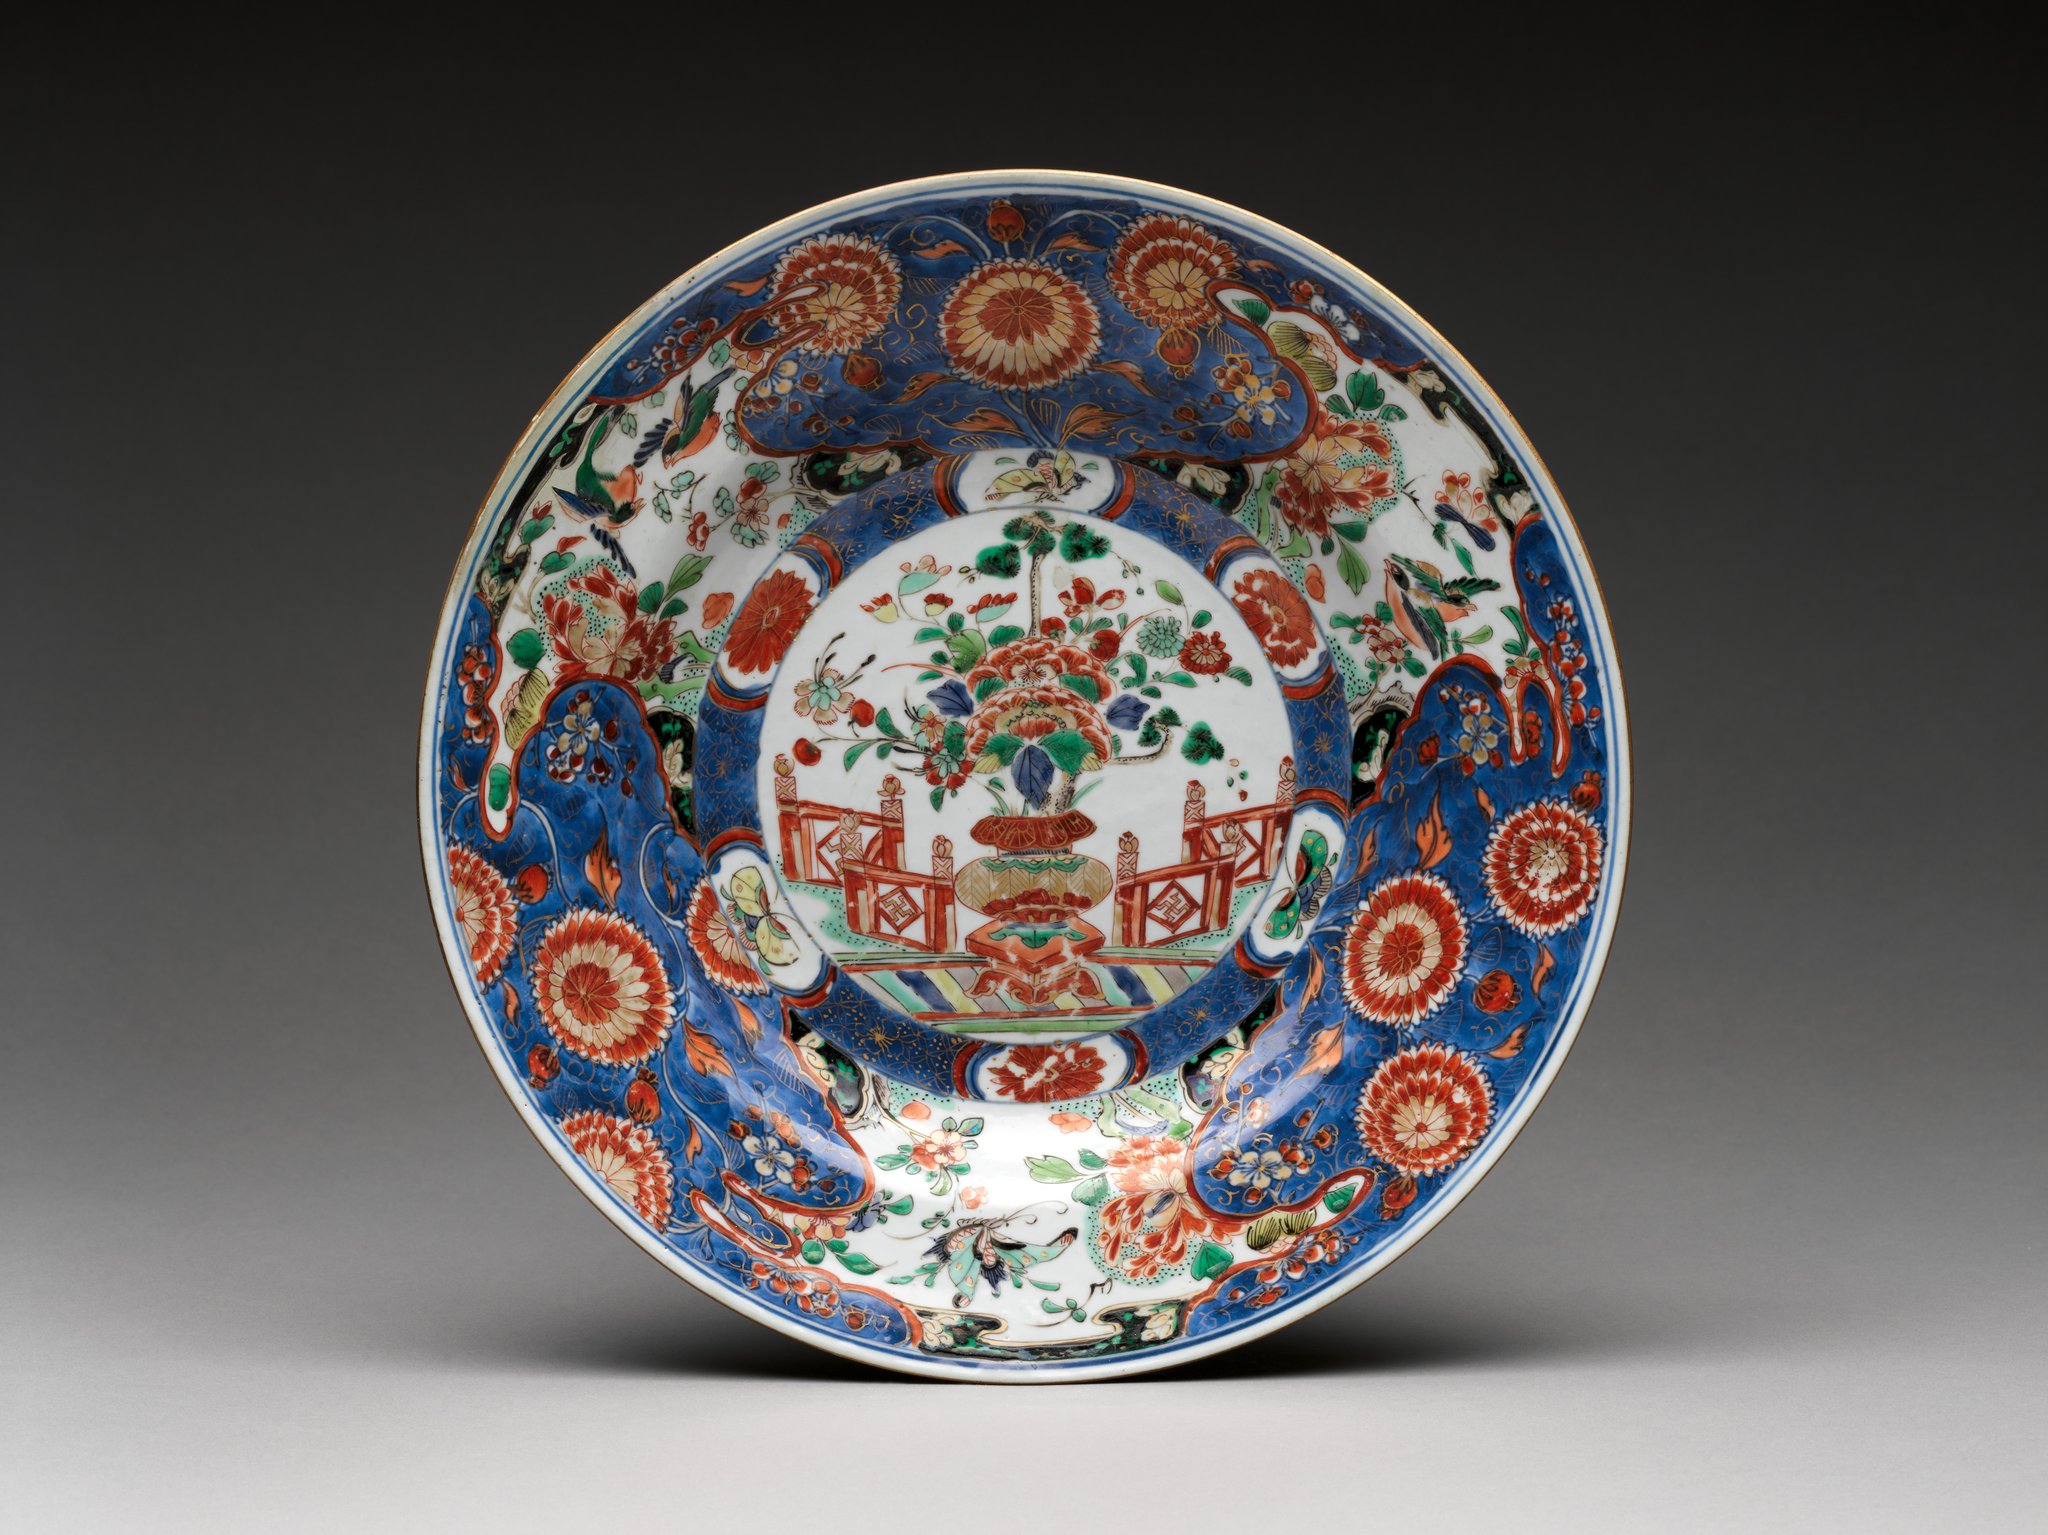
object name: dish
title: Dish with a vase of flowers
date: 1725-1730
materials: enamel, glaze, hard paste porcelain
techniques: gilding, painting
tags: flowers